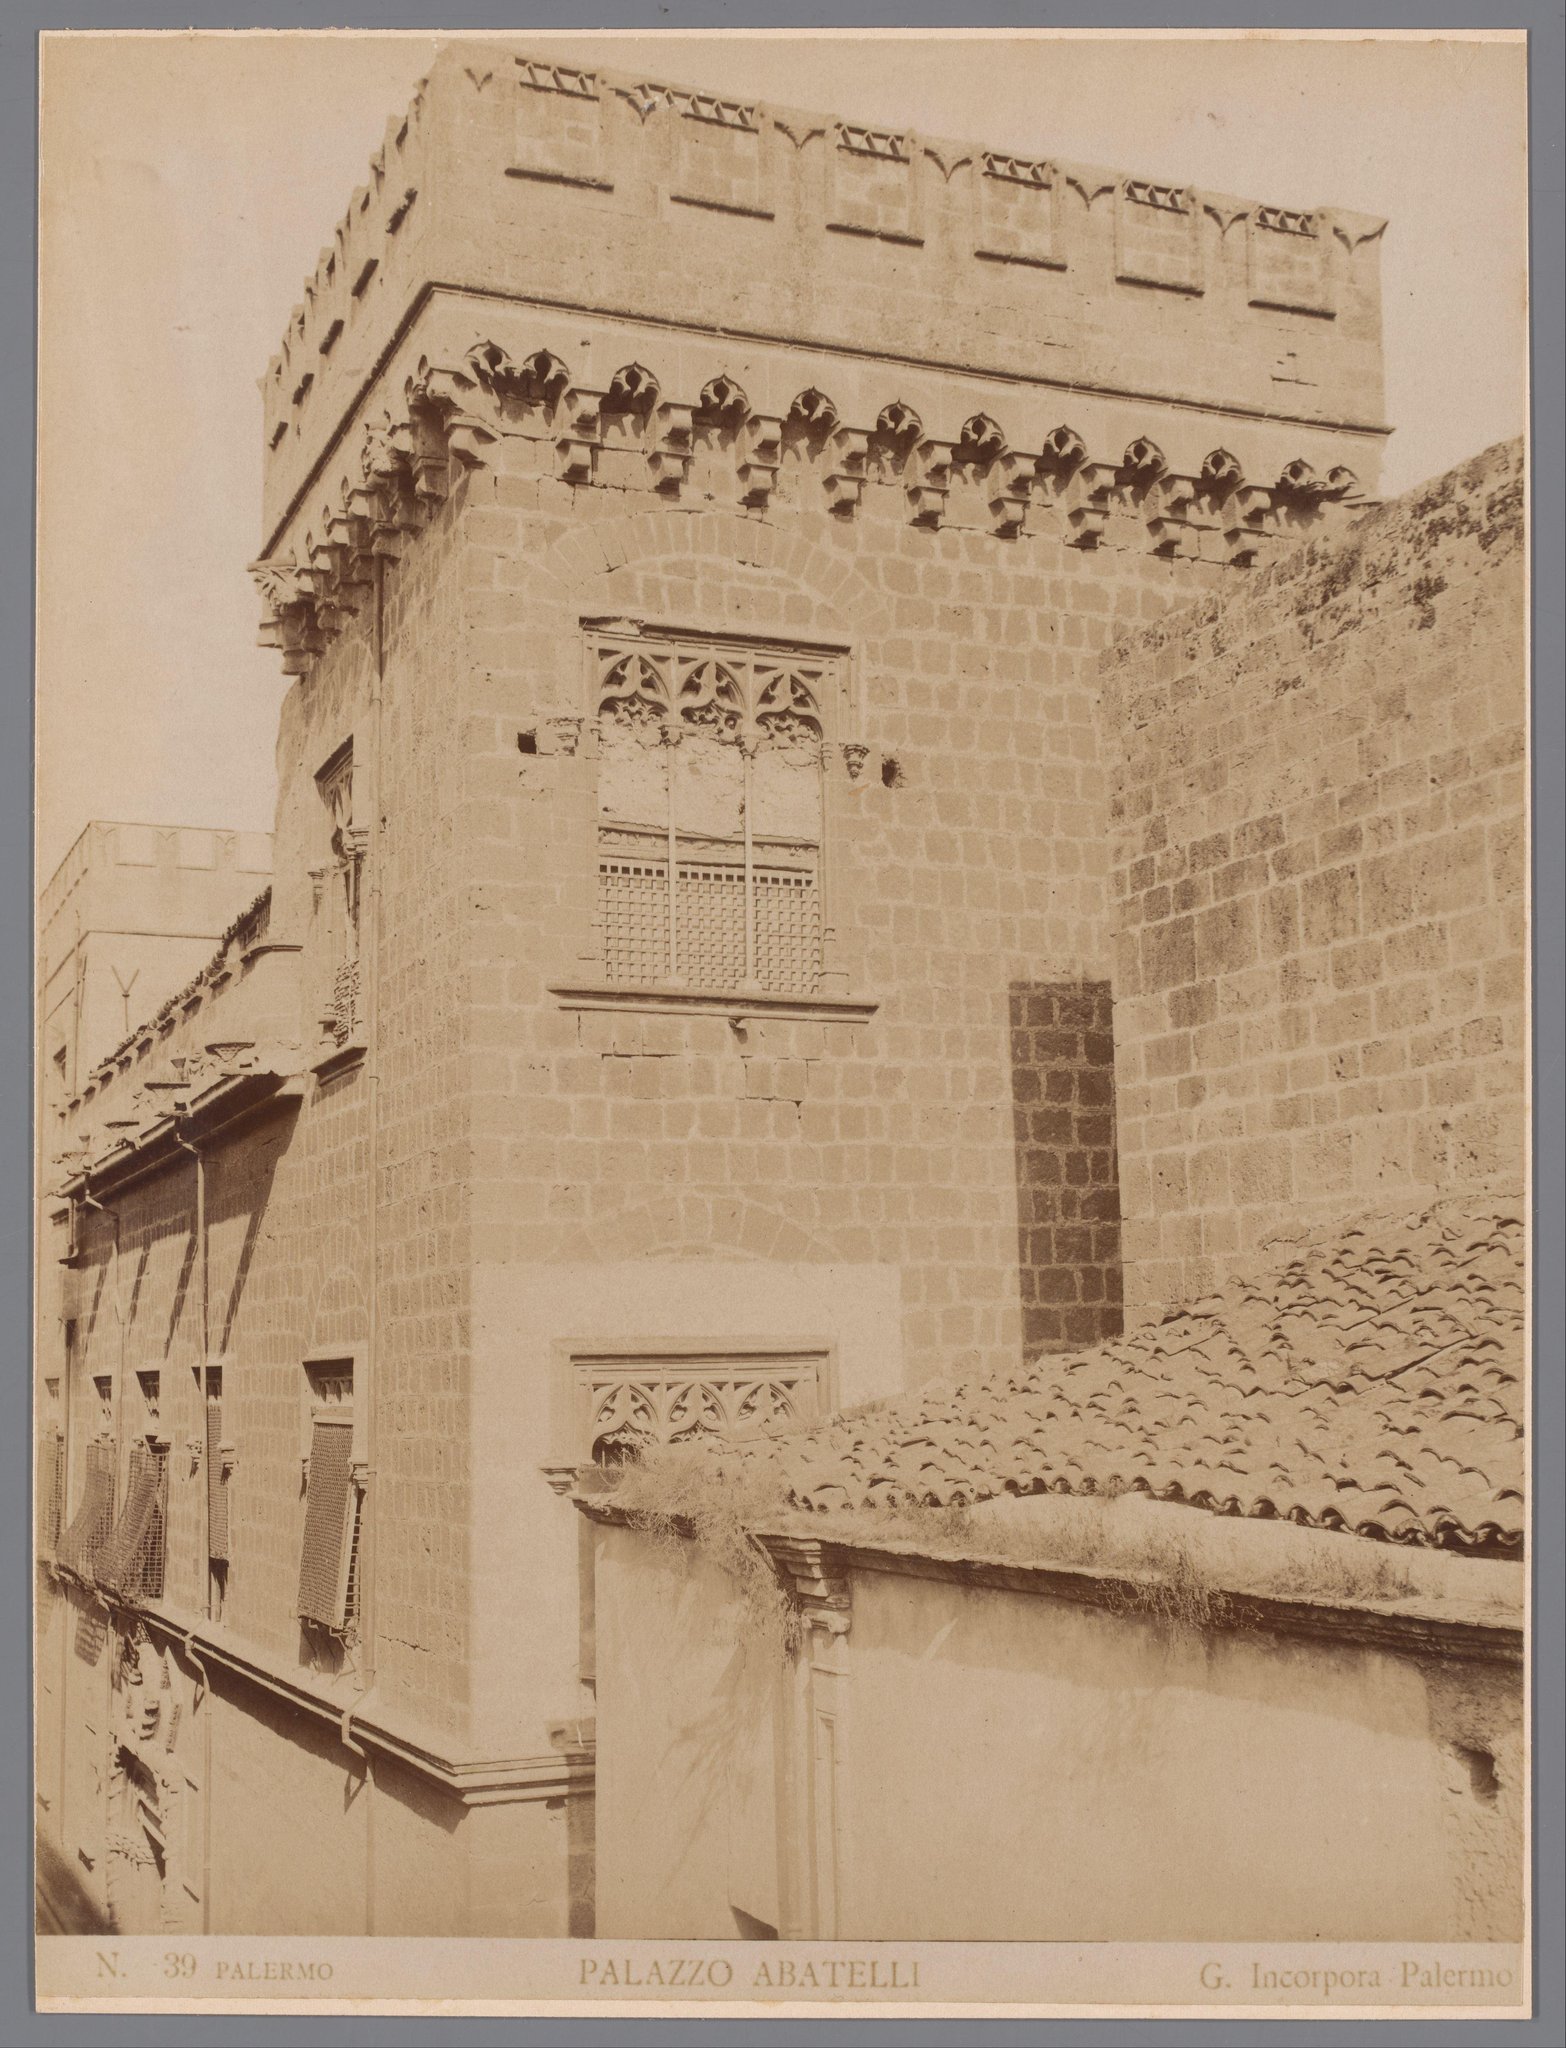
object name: photograph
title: Palazzo Abatelli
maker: giuseppe incorpora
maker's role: fotograaf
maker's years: 1834-1914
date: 1856-1914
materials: cardboard, paper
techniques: albumen print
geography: palermo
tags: hôtel, i.e. small palace in city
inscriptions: number: ‘N. 39’